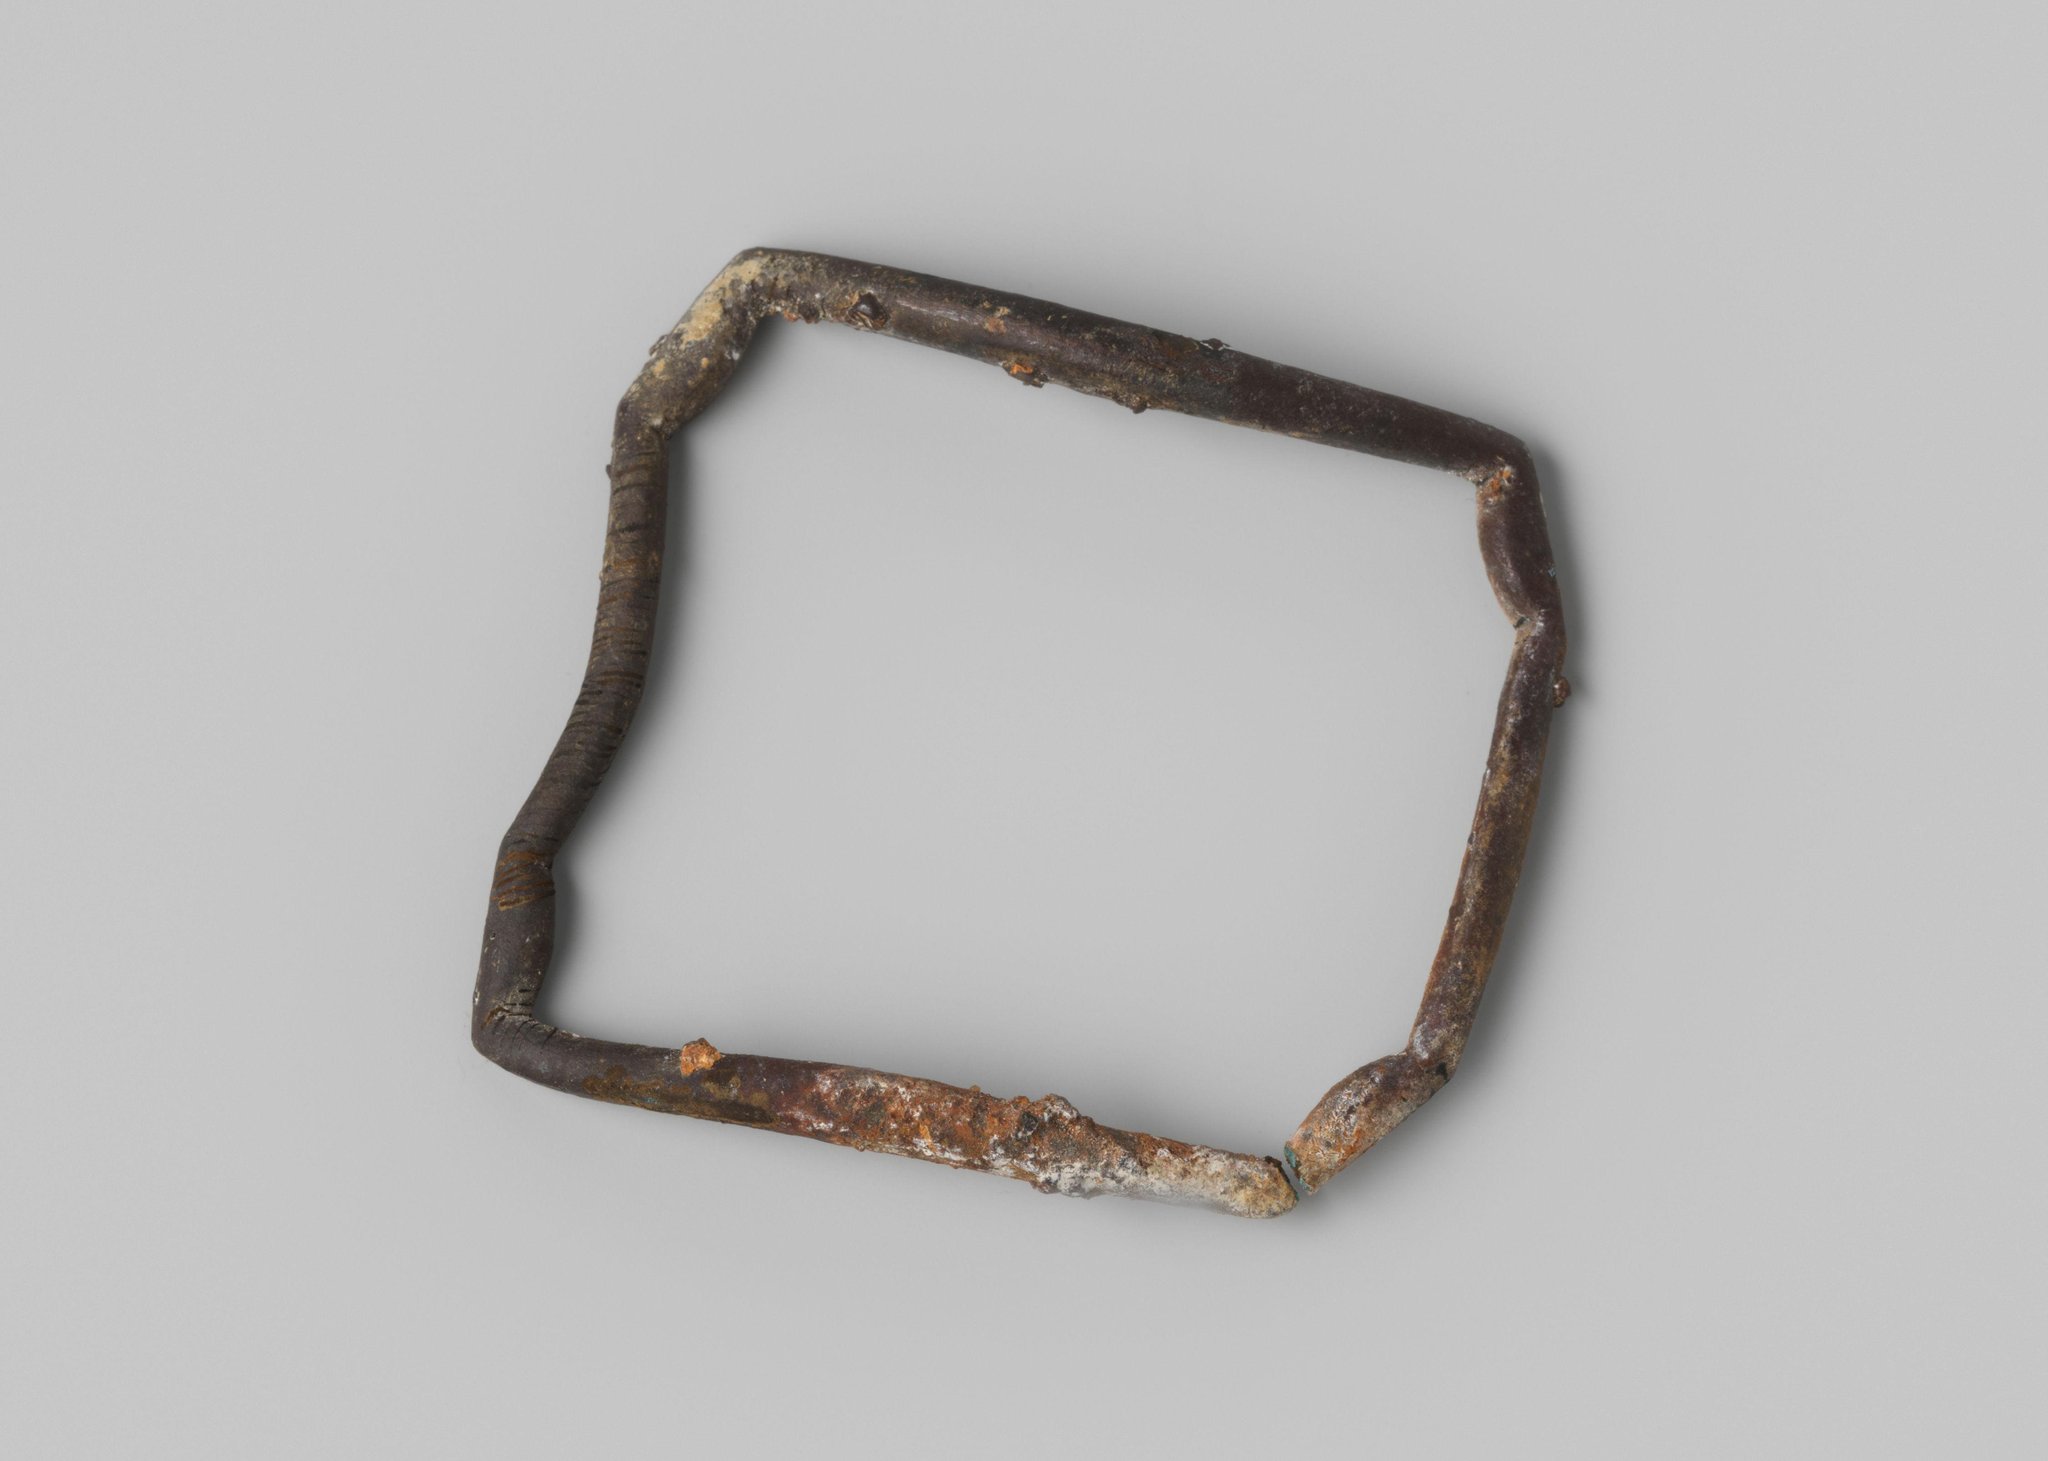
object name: shoe buckle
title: Schoengesp uit het wrak van de Oost-Indiëvaarder Hollandia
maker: Anonymous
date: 1700-1743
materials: copper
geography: netherlands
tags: verenigde oostindische compagnie, hollandia (schip), annet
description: Buckle, chape buckle, shoe buckle; ring, thin strip-shaped, octagonal outline.